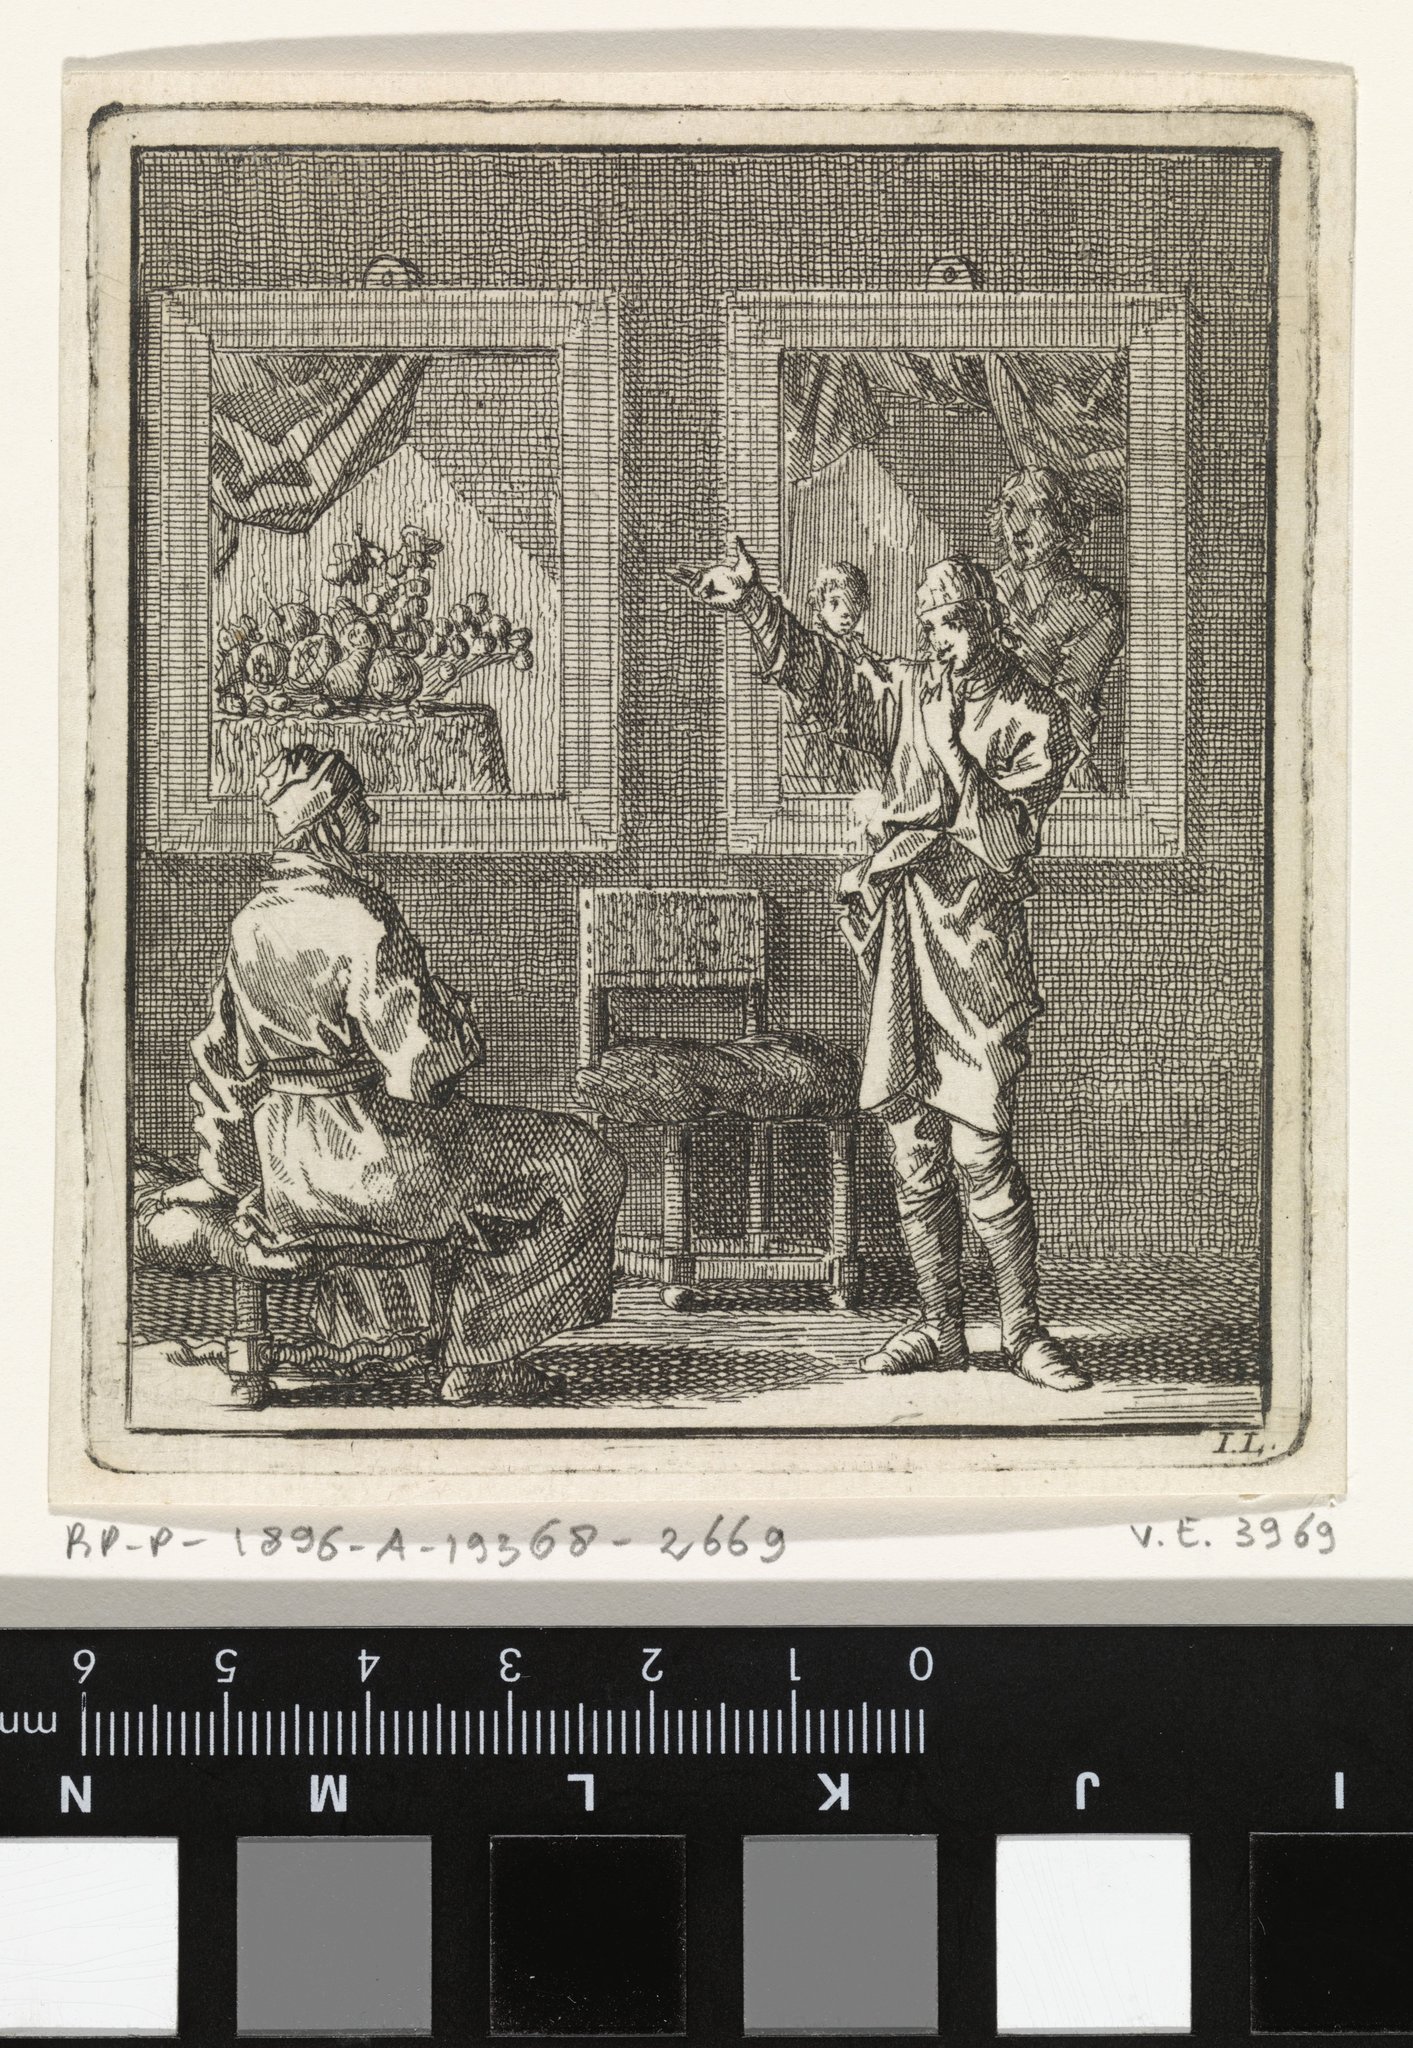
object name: book illustration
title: De Schildery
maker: jan luyken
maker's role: draughtsman, print maker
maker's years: 1649-1712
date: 1711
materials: paper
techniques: etching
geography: amsterdam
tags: picture within picture, picture, painting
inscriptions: collector's mark: Lugt 2228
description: Illustratie voor: Luyken, Jan. Het leerzaam huisraad, vertoond in vyftig konstige figuuren, met godlyke spreuken en stichtelyke verzen: Pieter Arentsz. II (wed.) en Cornelis van der Sys, 1711, p. 68.